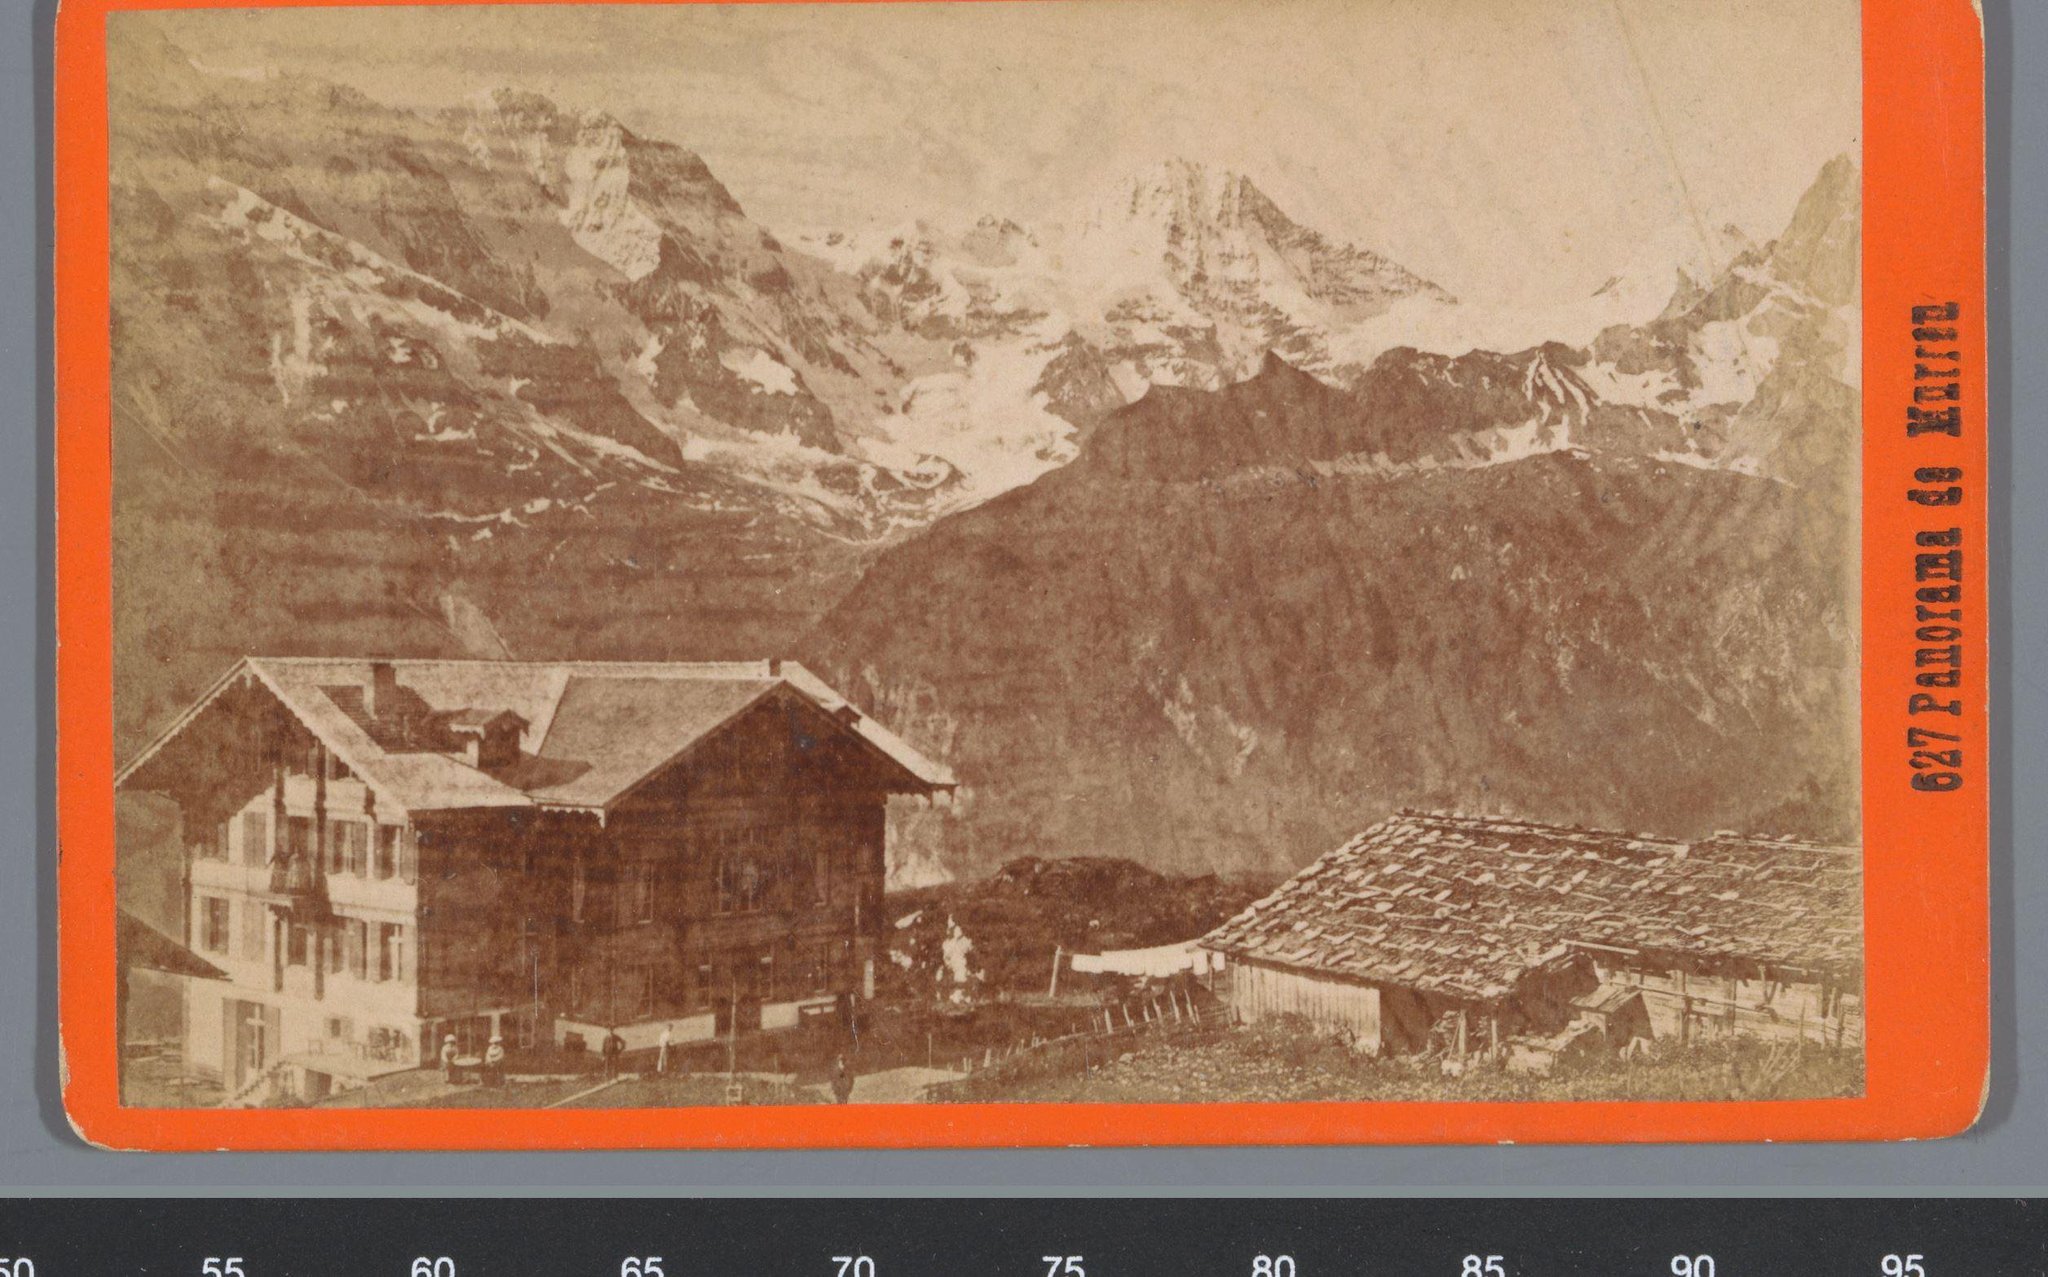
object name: photograph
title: Panorama de Murren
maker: arthur gabler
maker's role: publisher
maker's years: 1867-1927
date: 1873-1889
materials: cardboard, paper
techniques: albumen print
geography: mürren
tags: city-view in general; 'veduta', mountains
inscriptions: inscription: ‘WELTAUSSTELLUNG/ WIEN 1873/ ANERKENNUNGS DIPLOM’